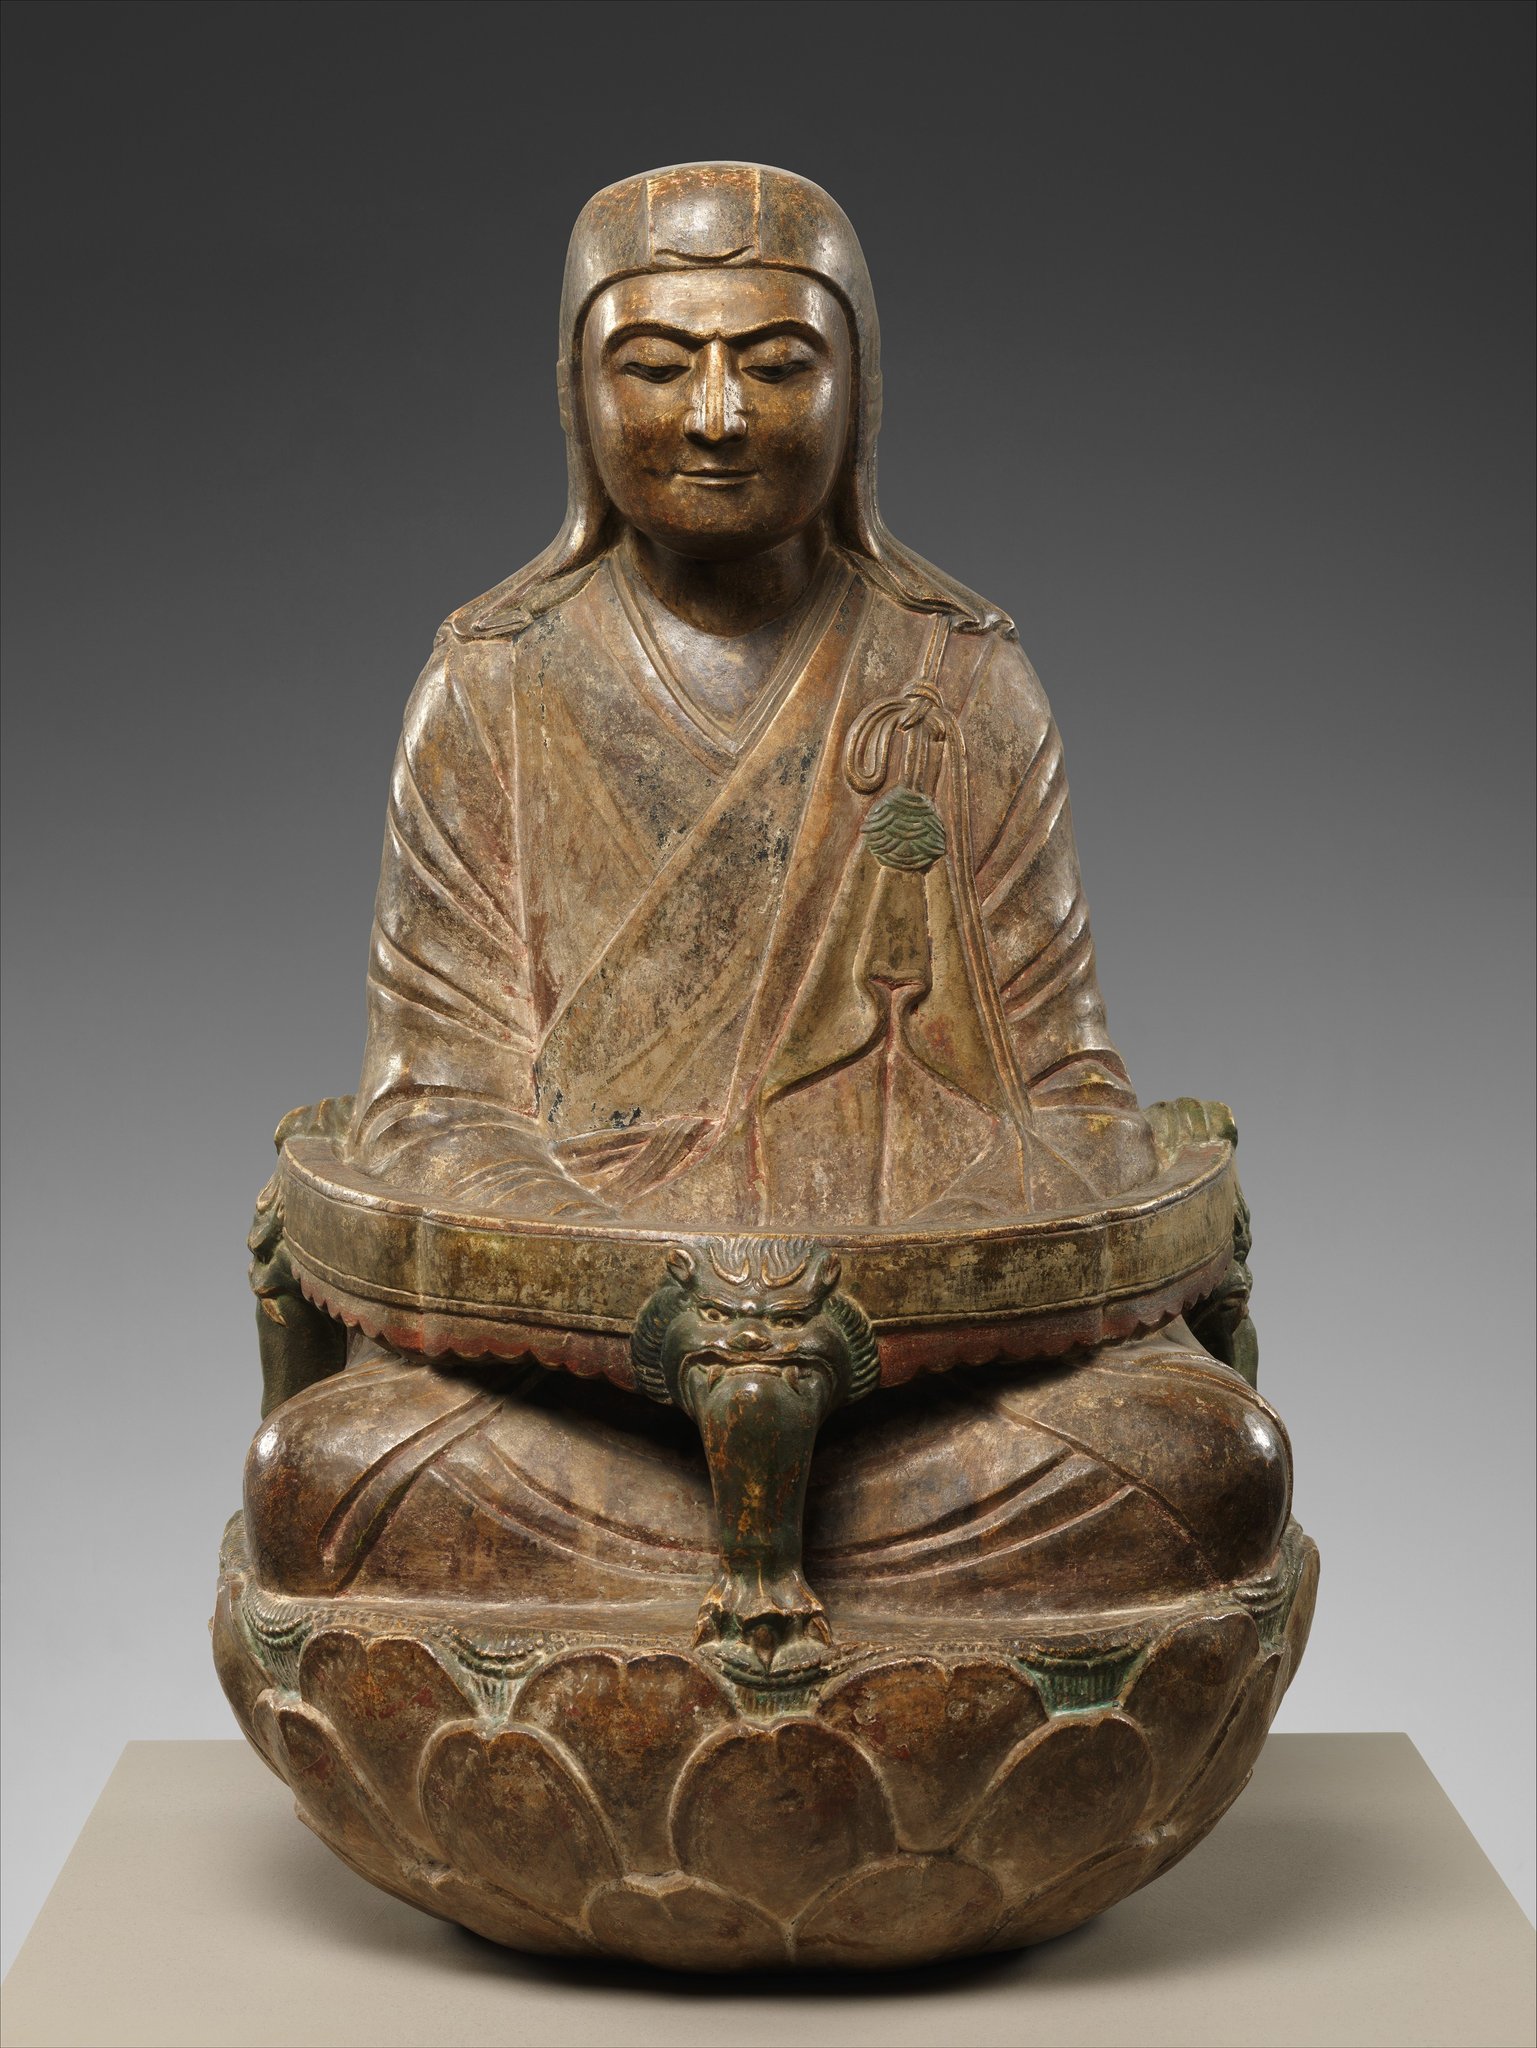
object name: figure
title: Monk Sengqie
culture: chinese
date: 1067-1200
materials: limestone, pigment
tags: monks